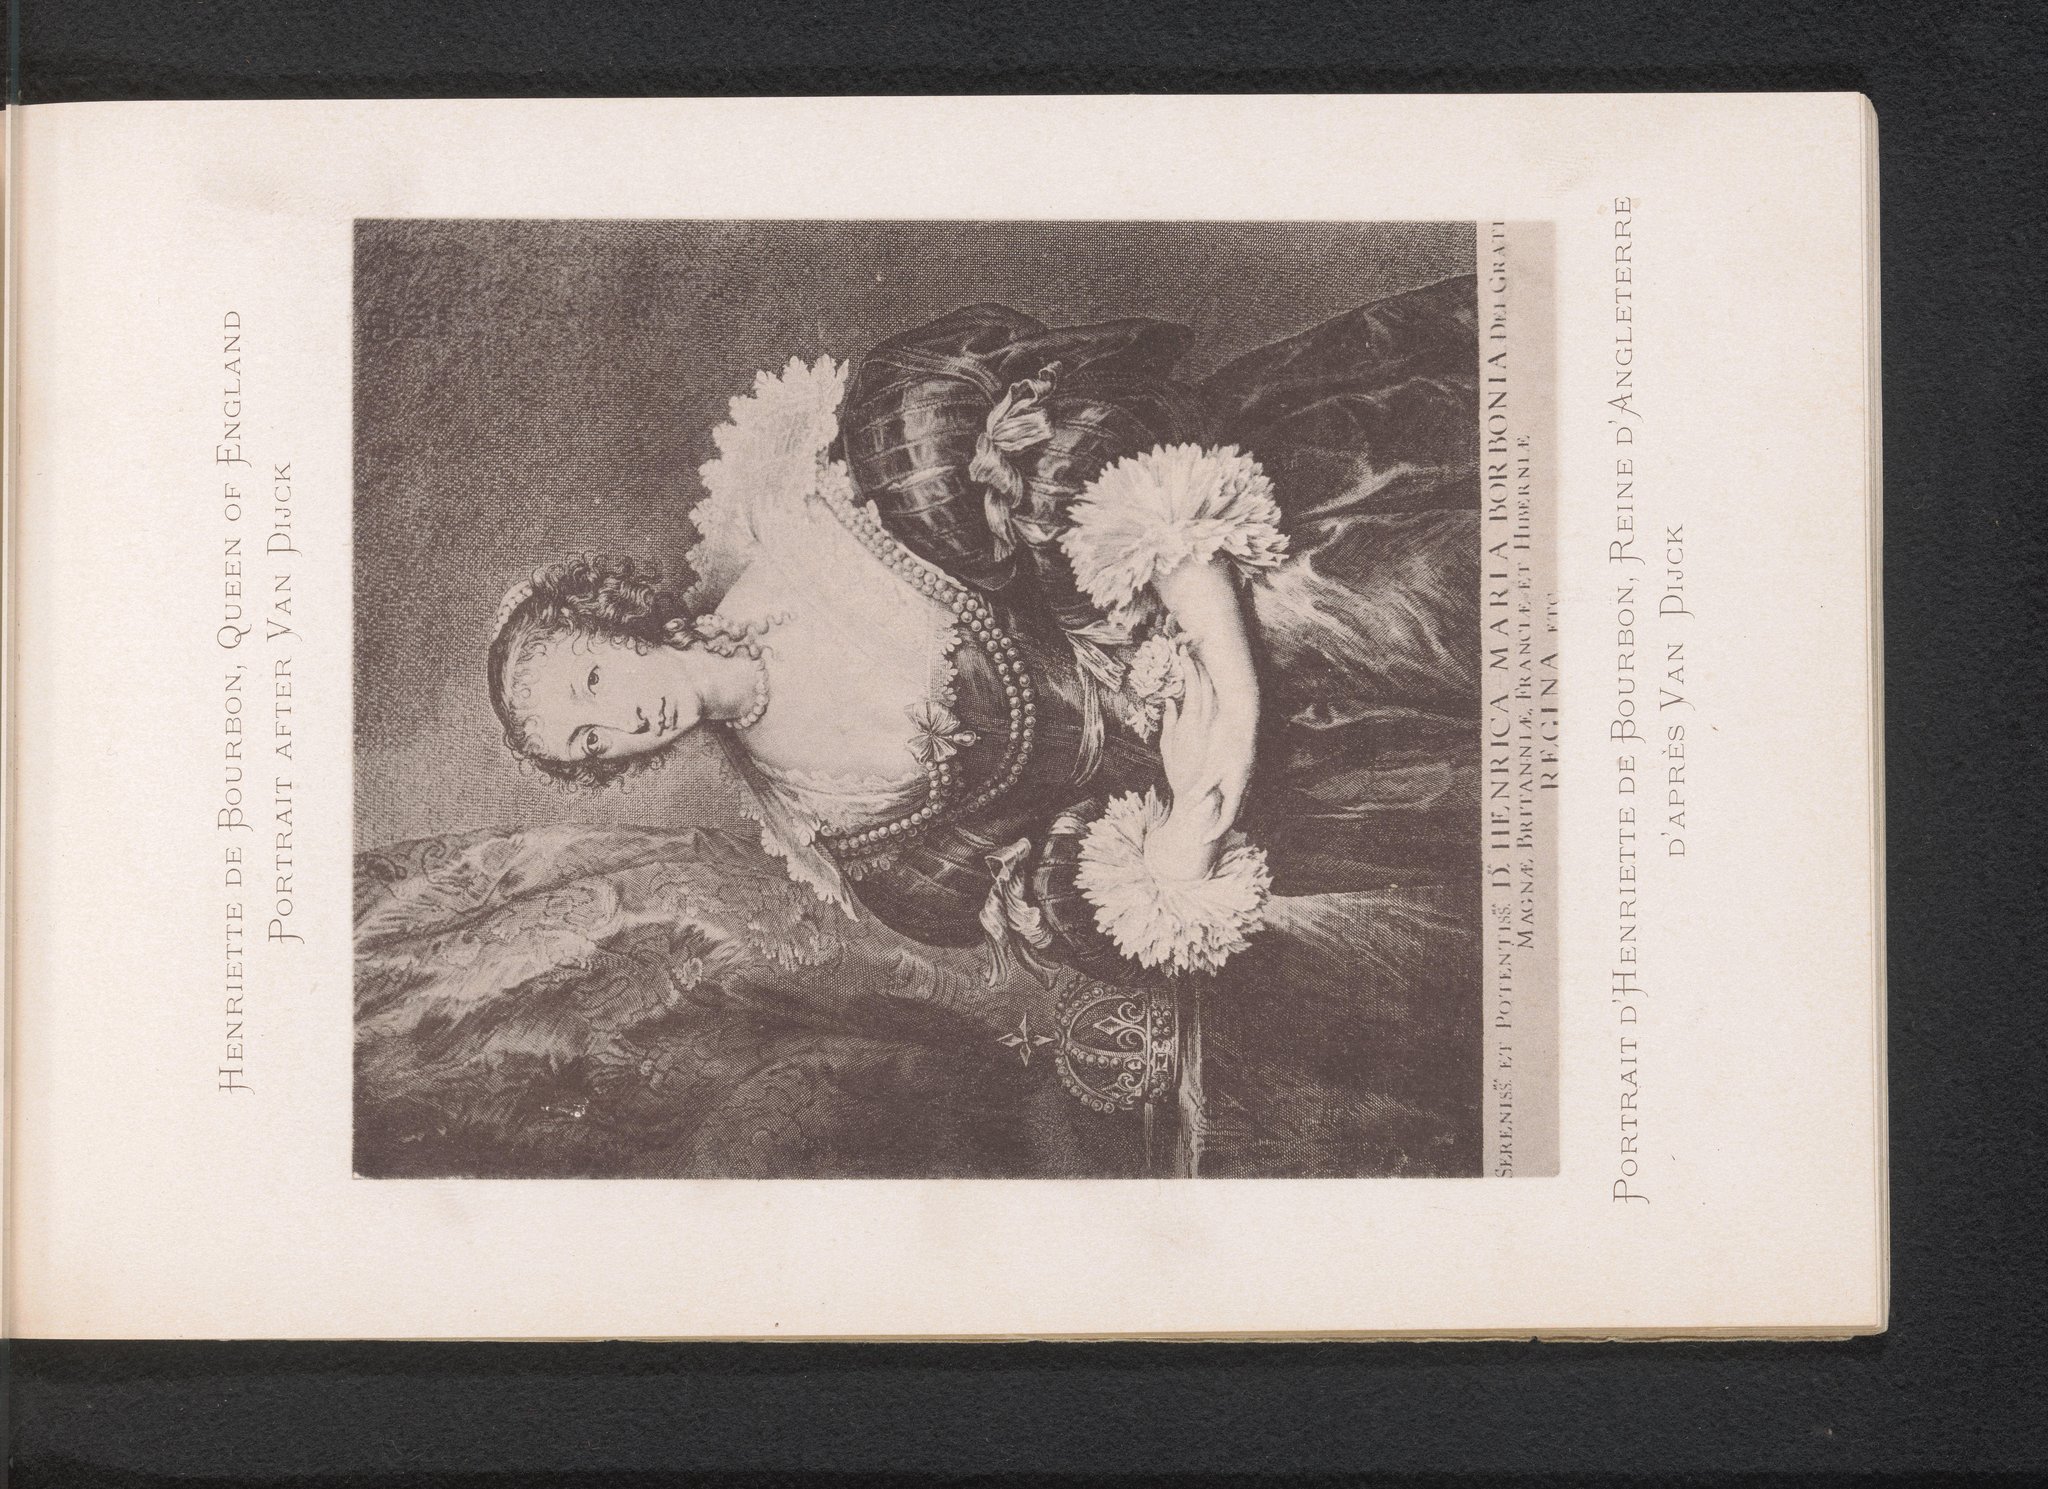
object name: page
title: Reproductie van een gegraveerd portret van Henriëtta Maria de Bourbon, koningin van Engeland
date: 1892-1897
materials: paper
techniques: photograph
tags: henriëtta maria van frankrijk (koningin van engeland, schotland en ierland), crown (symbol of sovereignty), adult woman, queen